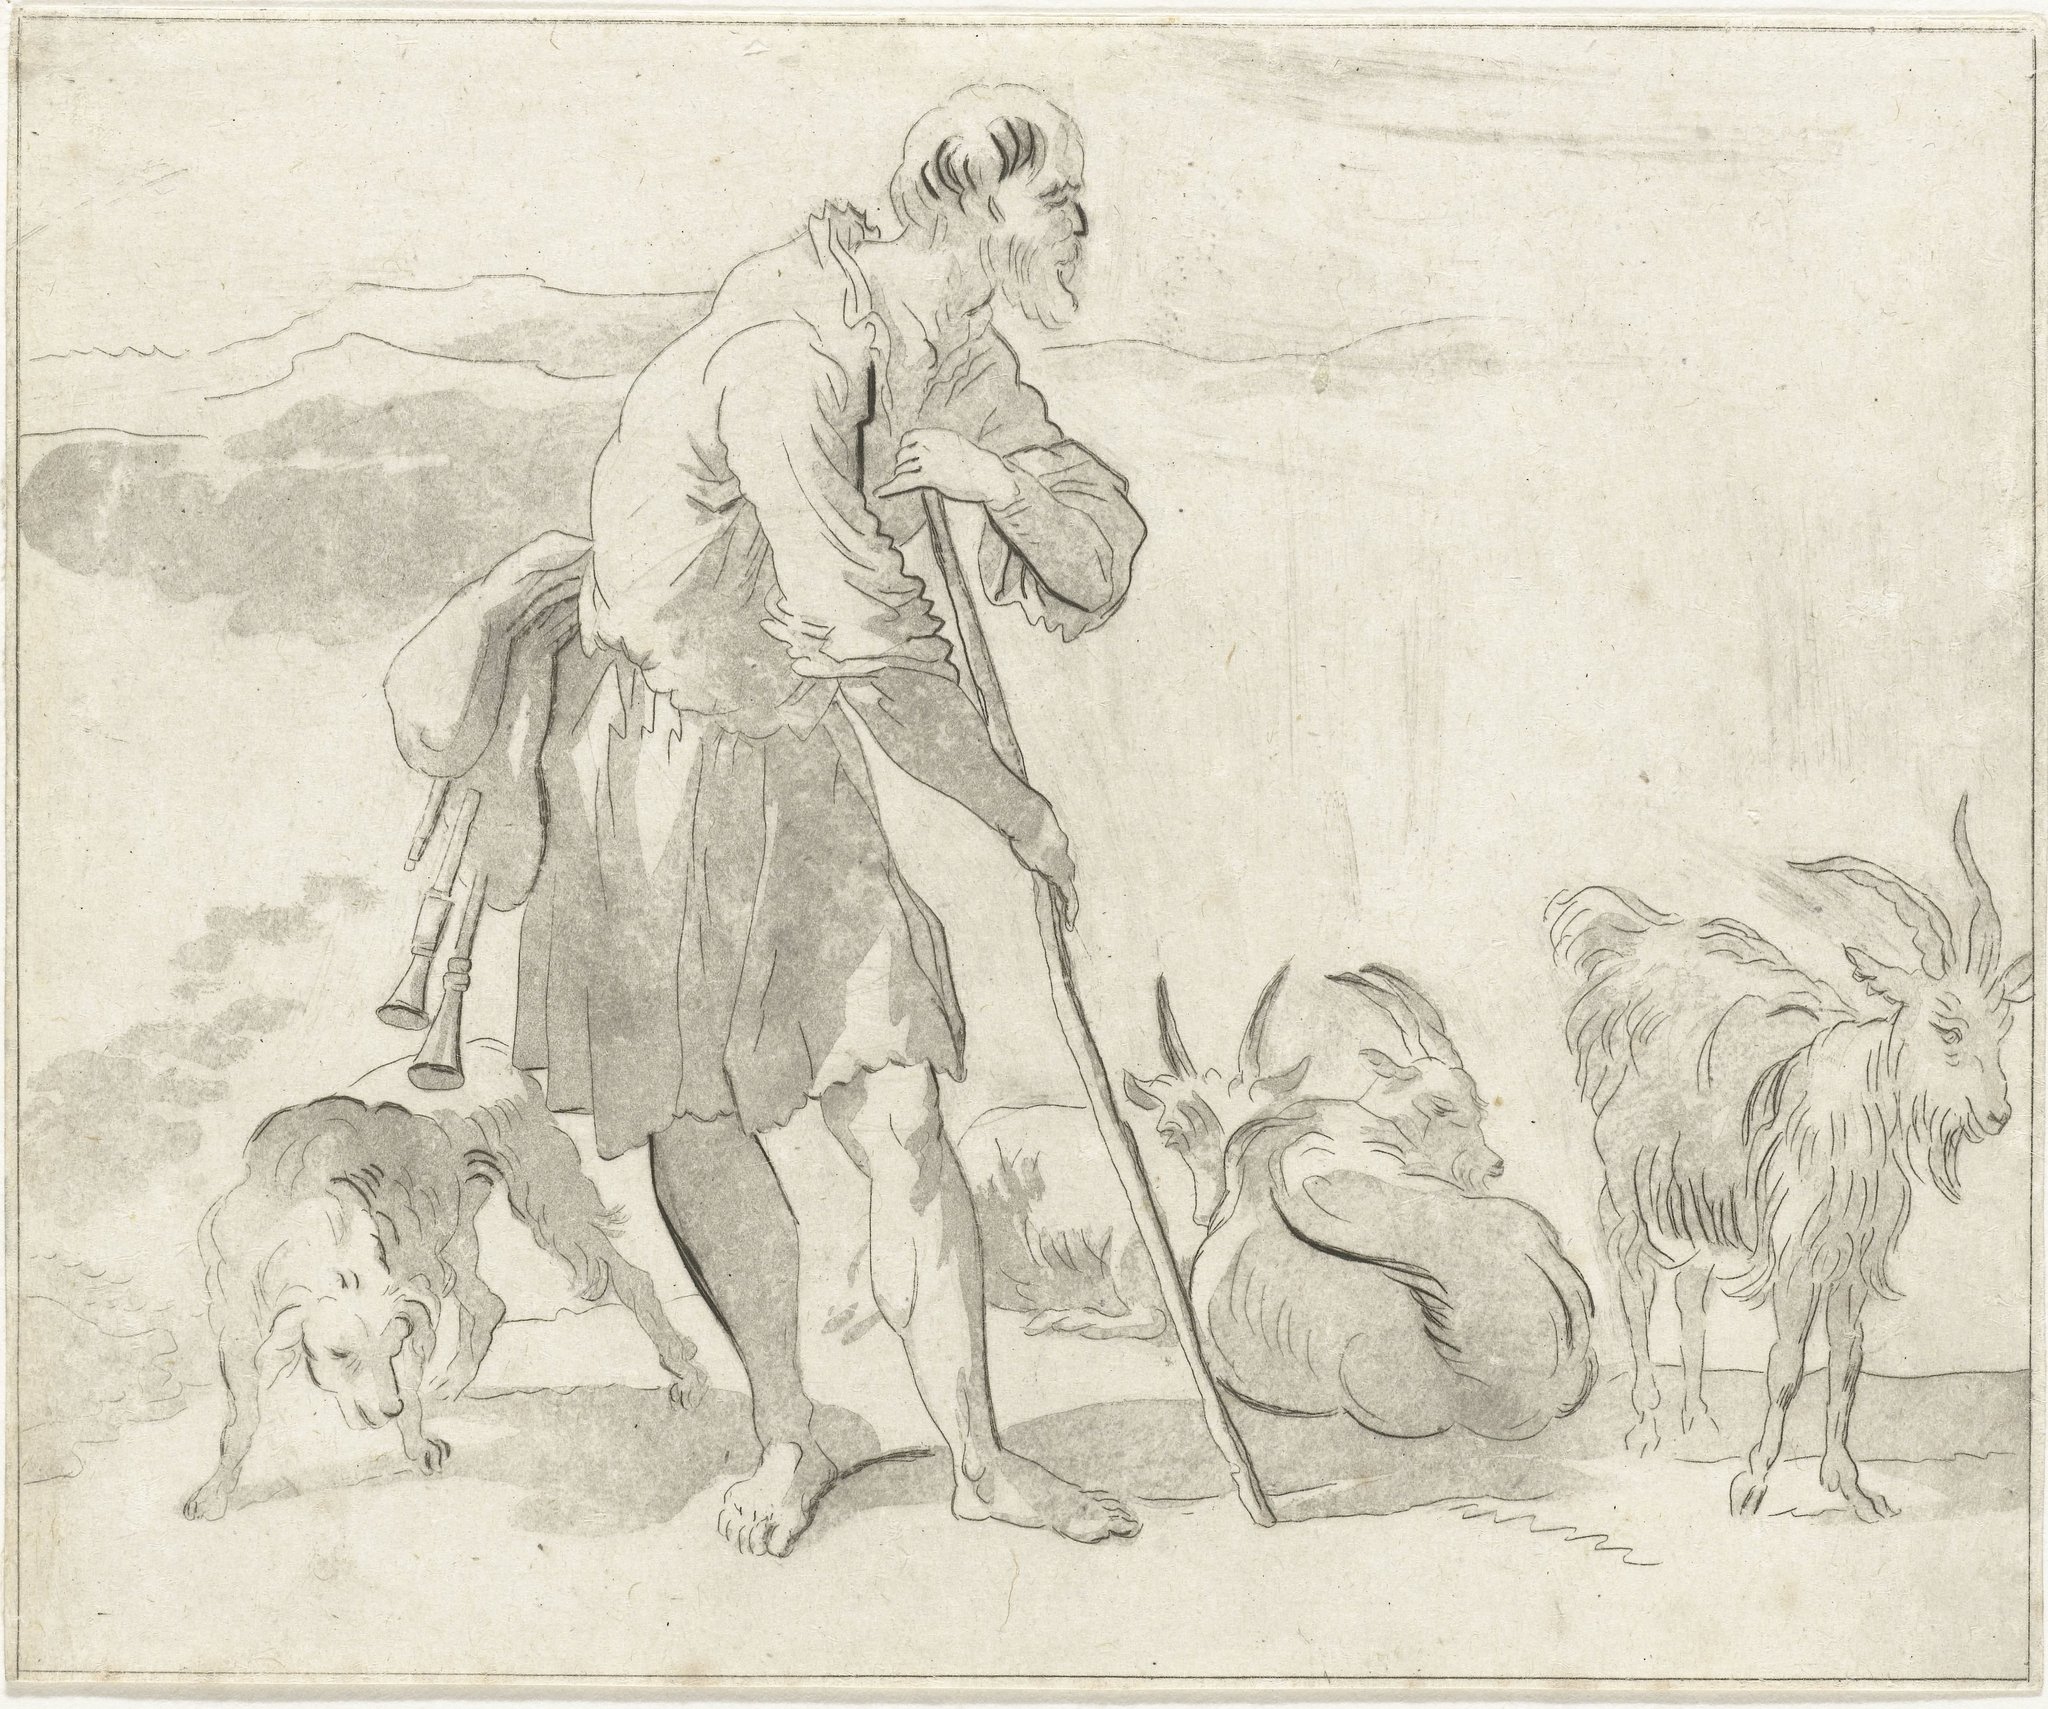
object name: print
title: Herder met geiten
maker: anthonie van den bos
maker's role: draughtsman, print maker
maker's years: 1763-1838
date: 1778-1838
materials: paper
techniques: aquatint, etching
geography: netherlands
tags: herding, herdsman, herdswoman, shepherd, shepherdess, cowherd, etc., bagpipe, musette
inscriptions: collector's mark: Lugt 2228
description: Herder leunend op een stok, met drie geiten en een herdershond. Op zijn rug draagt de herder een doedelzak.